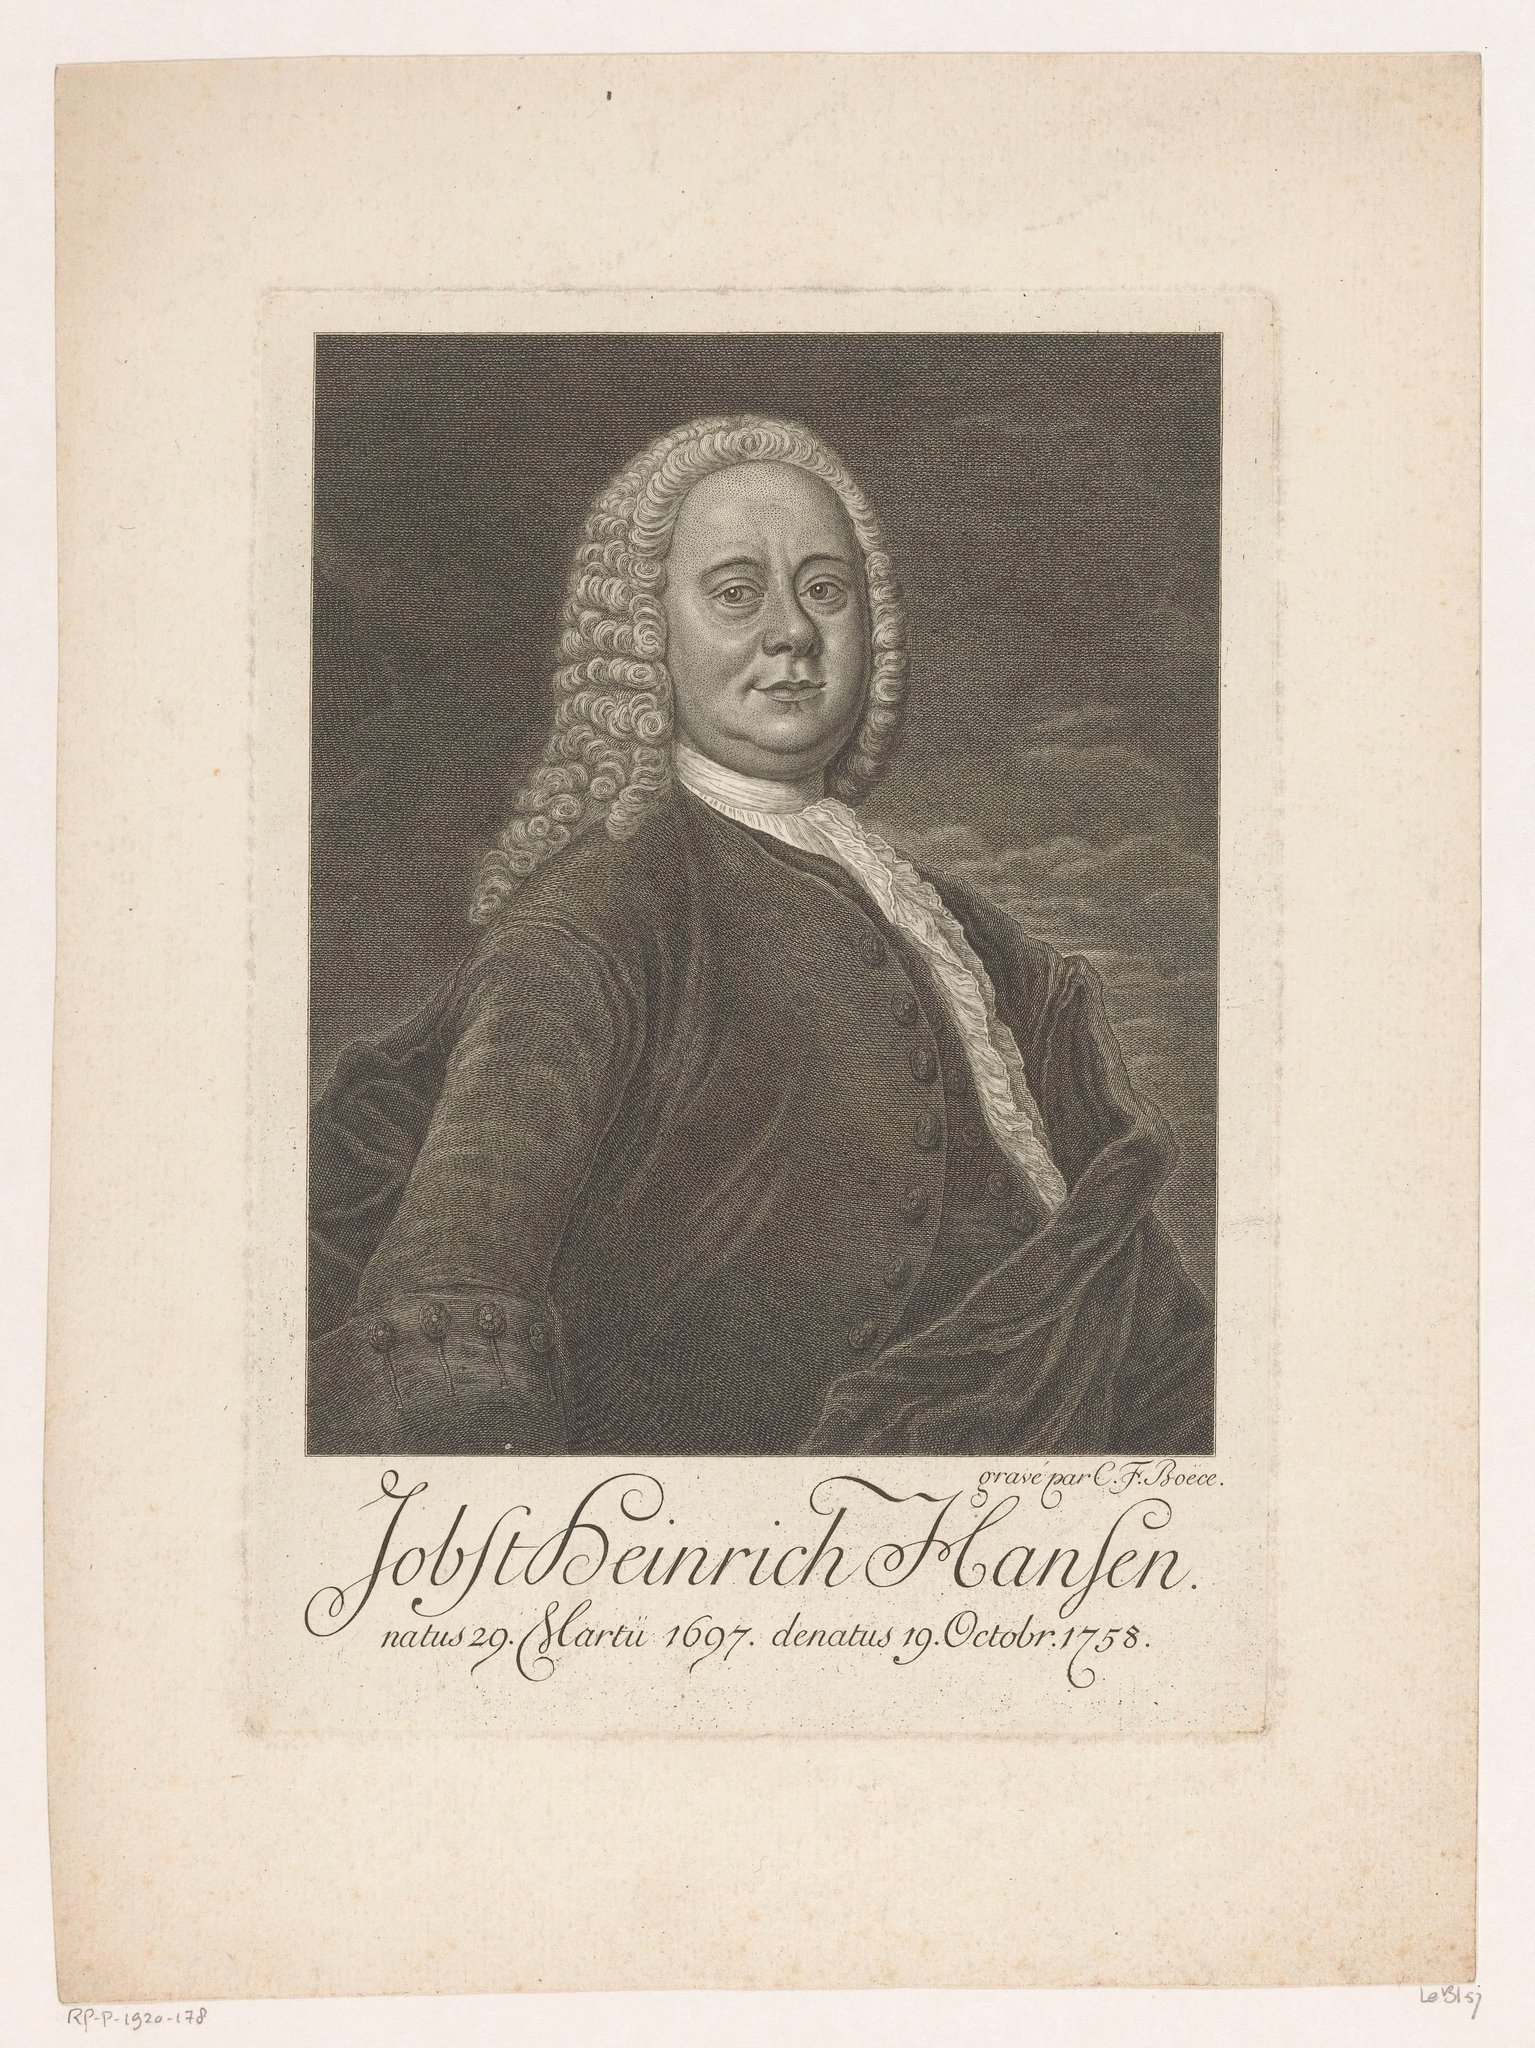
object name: print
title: Portret van Jobst Heinrich Hansen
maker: christian friedrich boëtius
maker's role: draughtsman, print maker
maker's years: 1706-1782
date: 1758-1782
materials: paper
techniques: engraving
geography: dresden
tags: historical persons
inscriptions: collector's mark: Lugt 2228